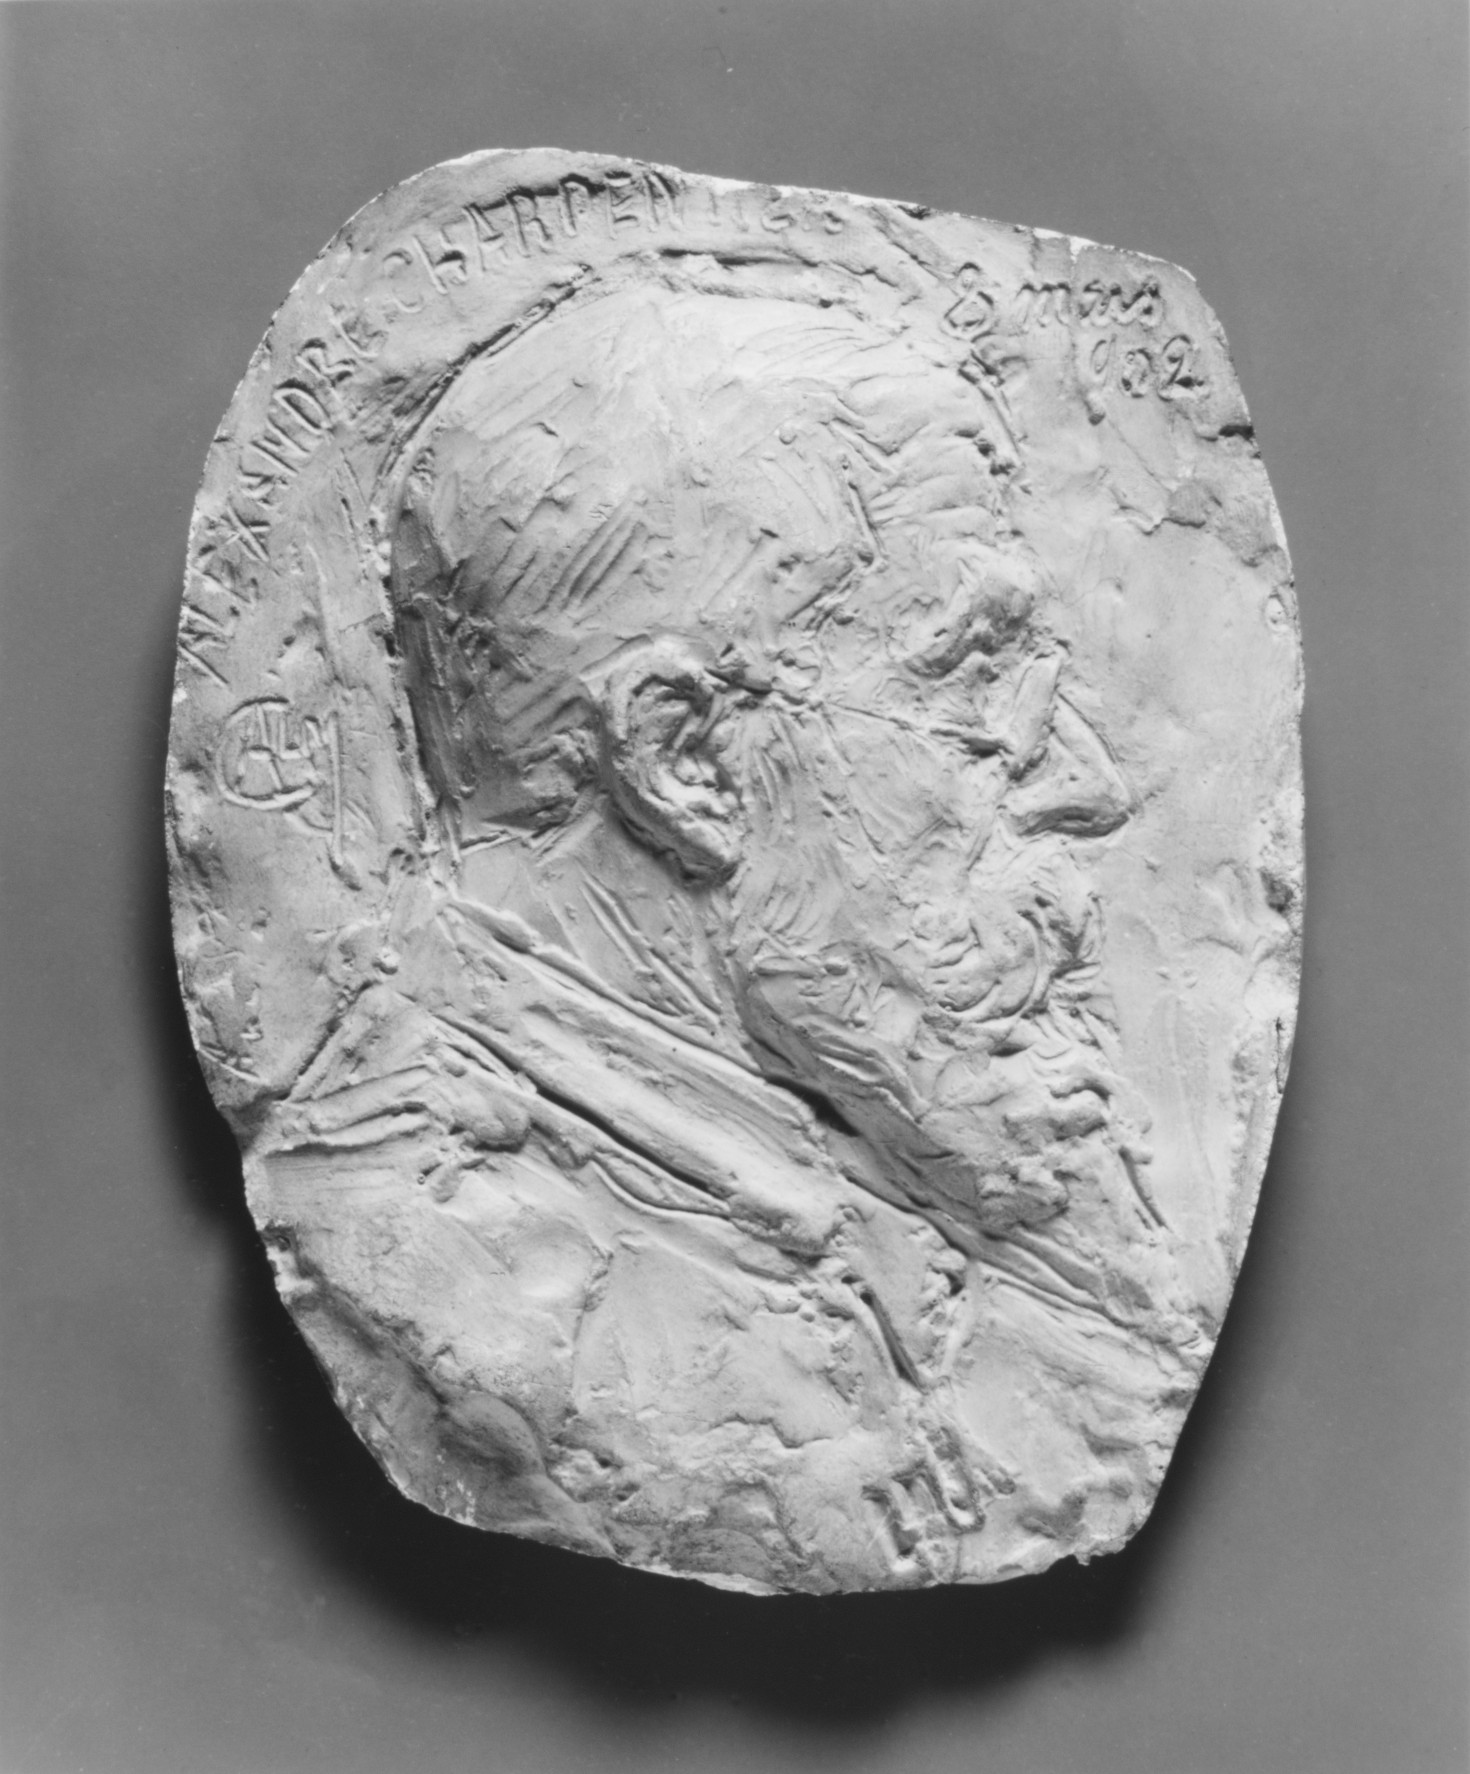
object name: relief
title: Self-Portrait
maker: alexandre-louis-marie charpentier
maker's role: artist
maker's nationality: french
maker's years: 1856-1909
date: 1902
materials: plaster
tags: men,profiles